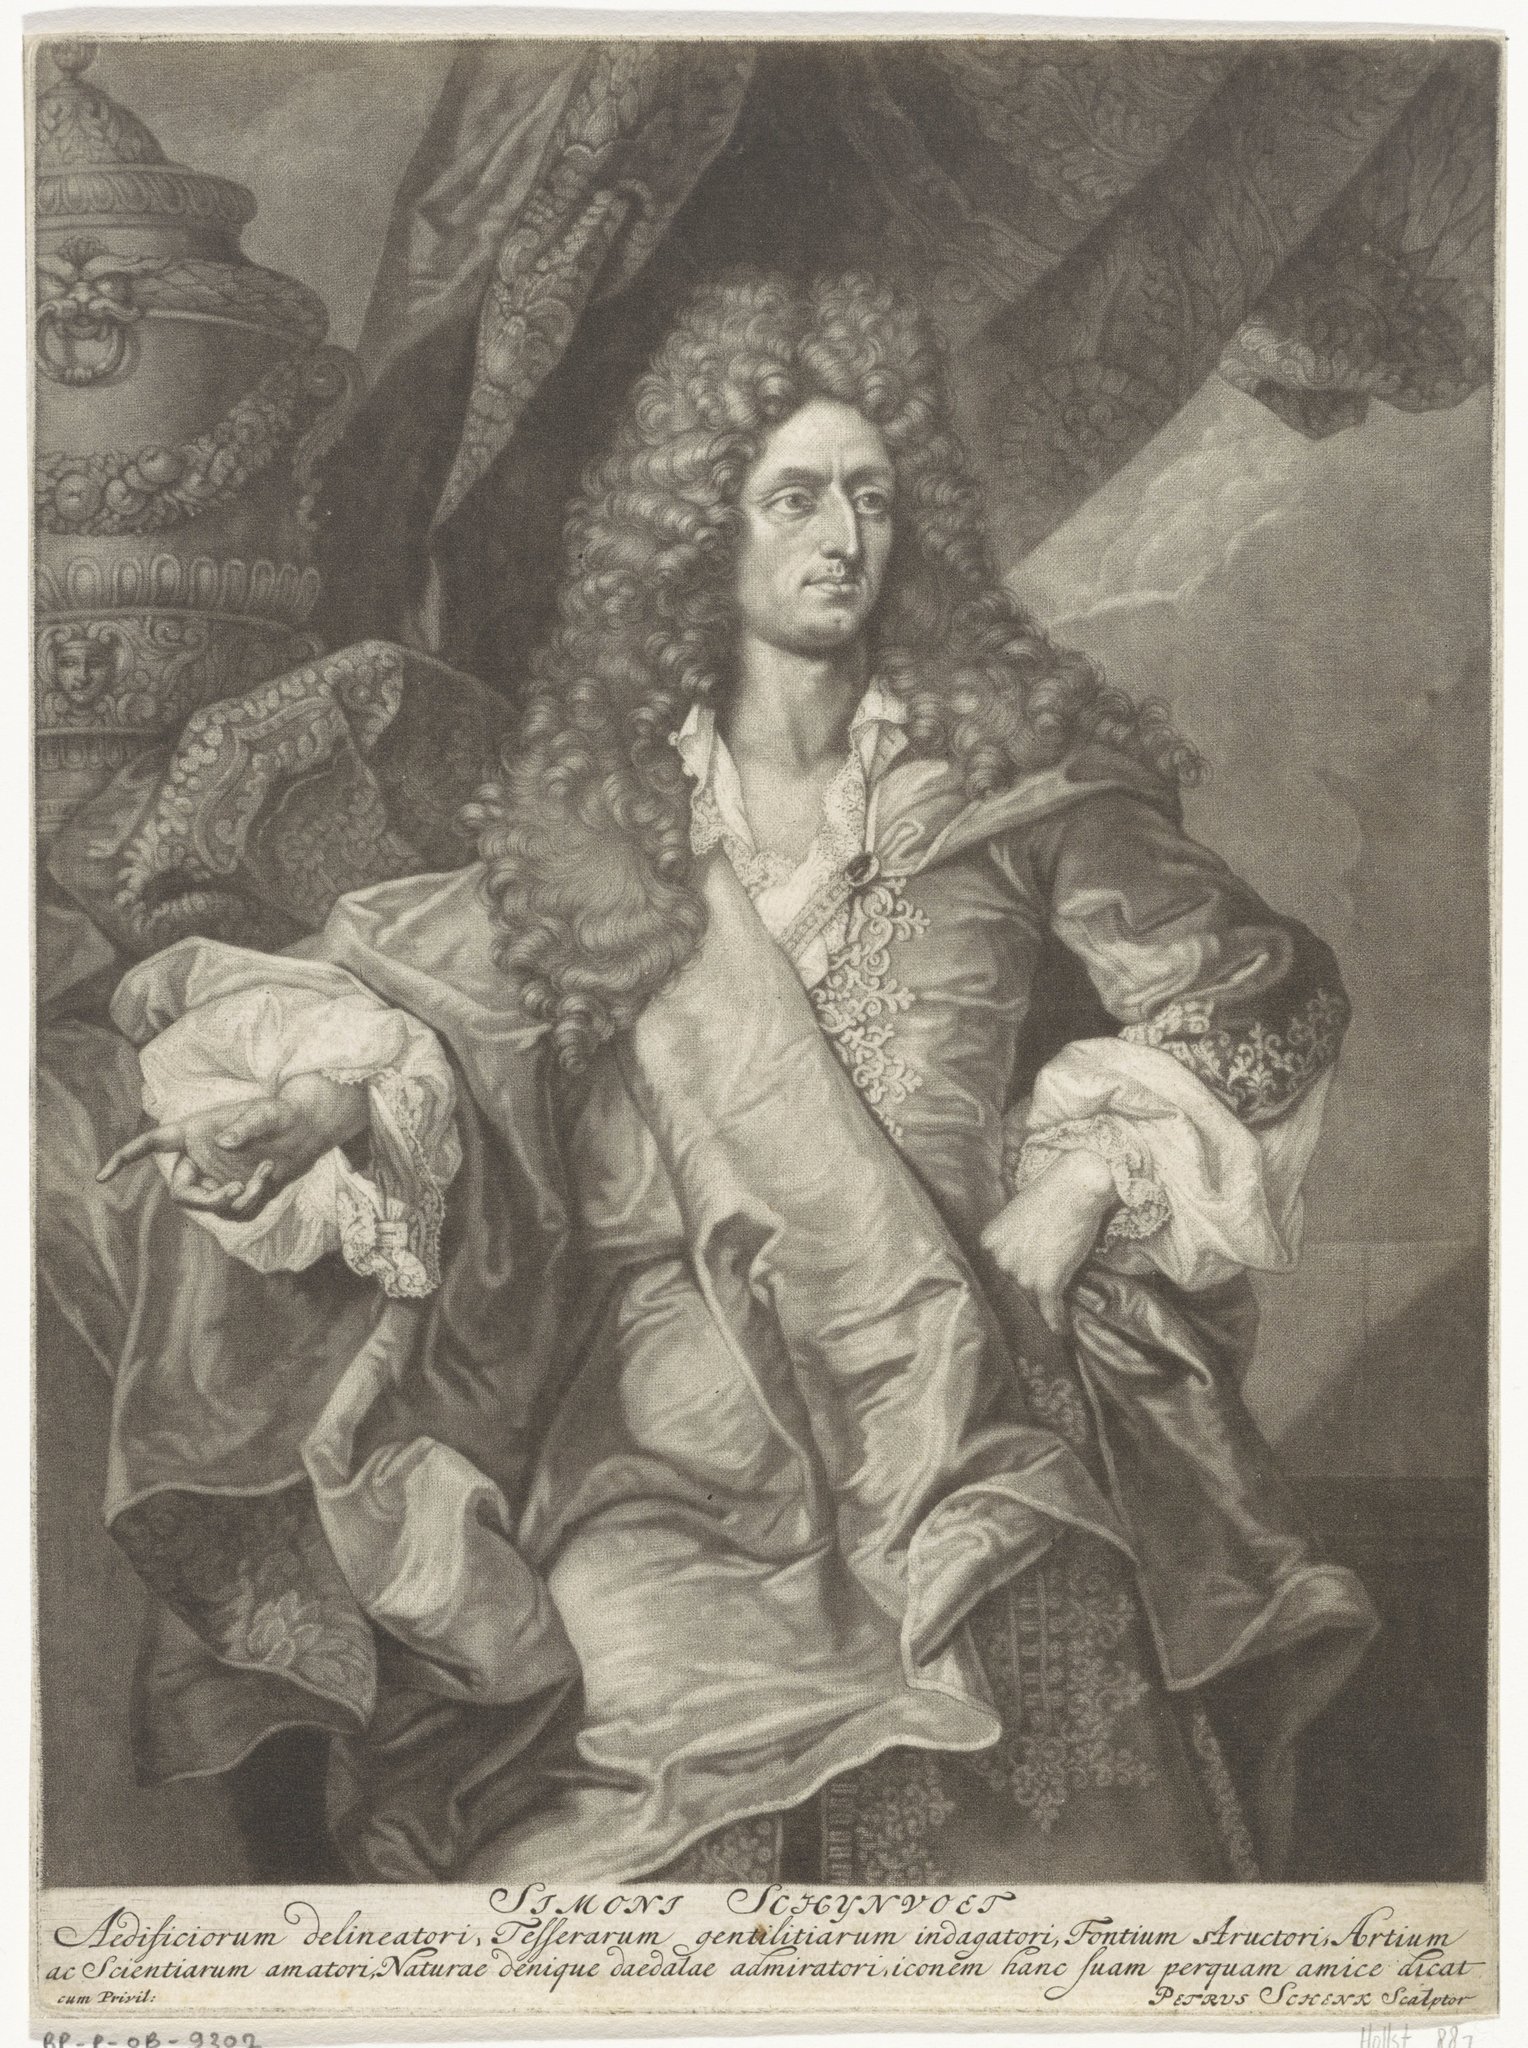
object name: print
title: Portret van Simon Schijnvoet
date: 1670-1713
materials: paper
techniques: engraving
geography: amsterdam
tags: simon schijnvoet, wig, urn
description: De architect Simon Schijnvoet wijst met zijn rechterhand. Achter hem een grote vaas, een draperie en wolken.